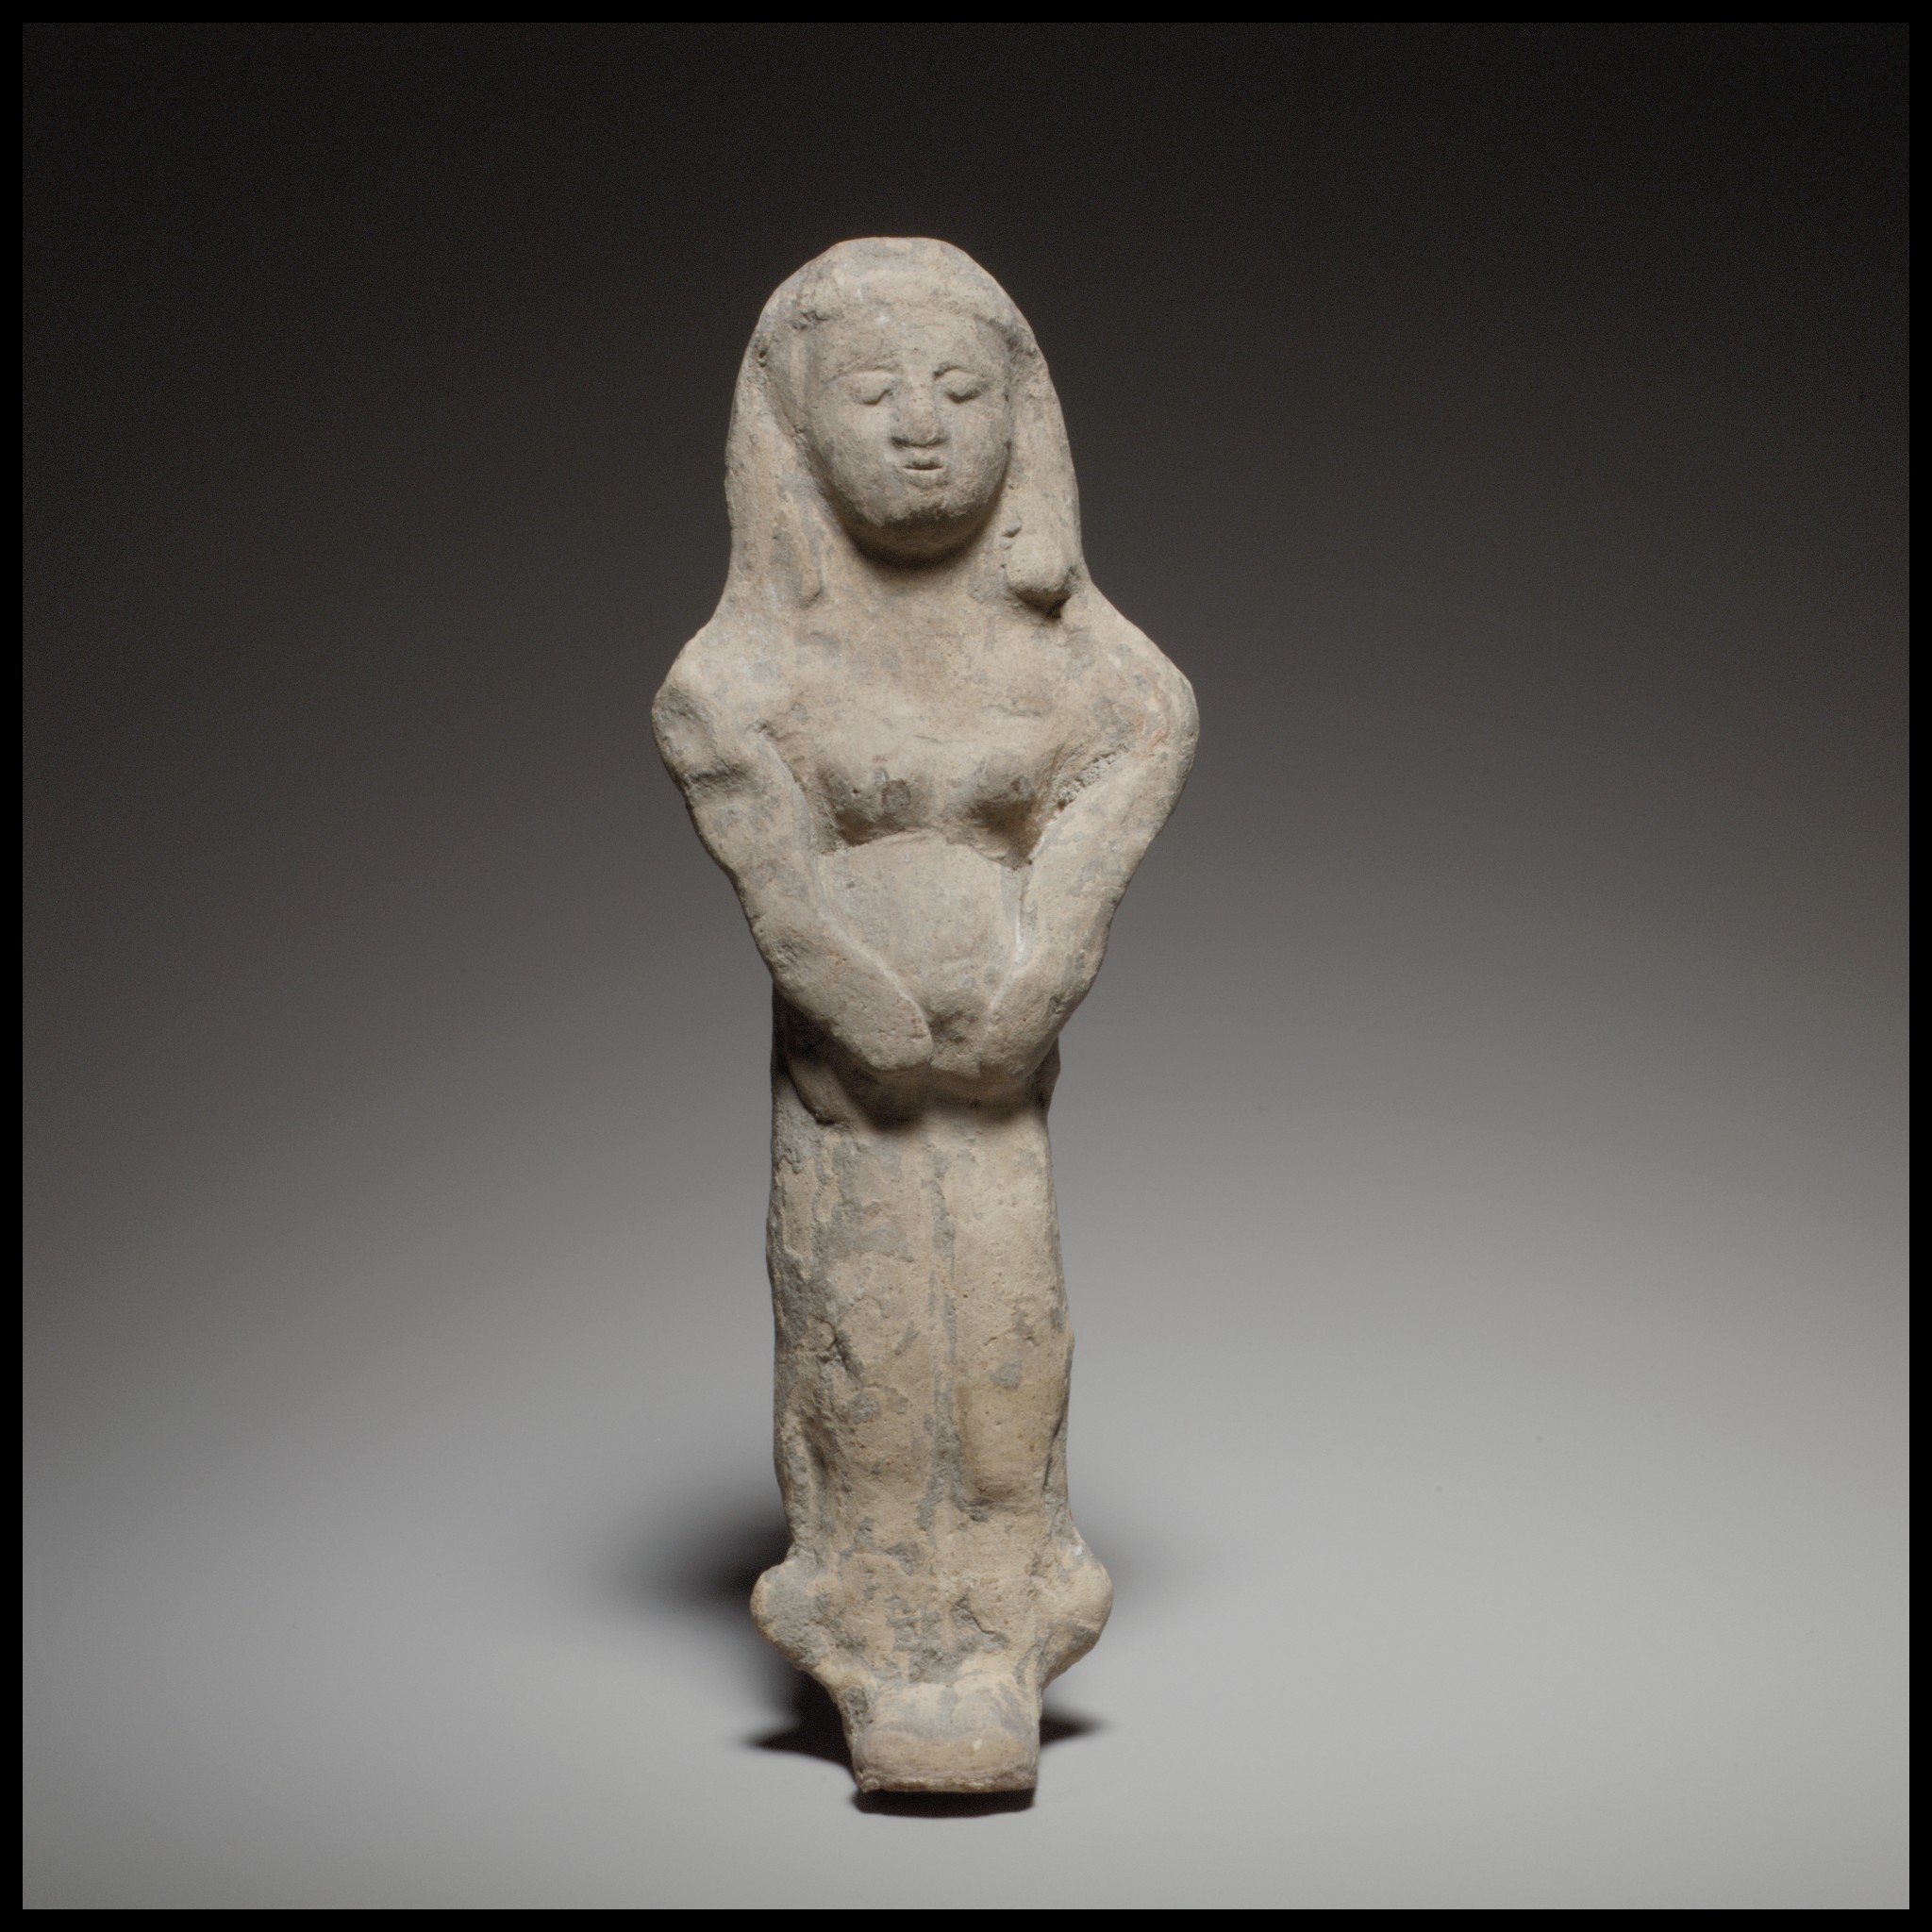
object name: statuette of a woman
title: Standing female figurine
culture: cypriot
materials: terracotta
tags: women